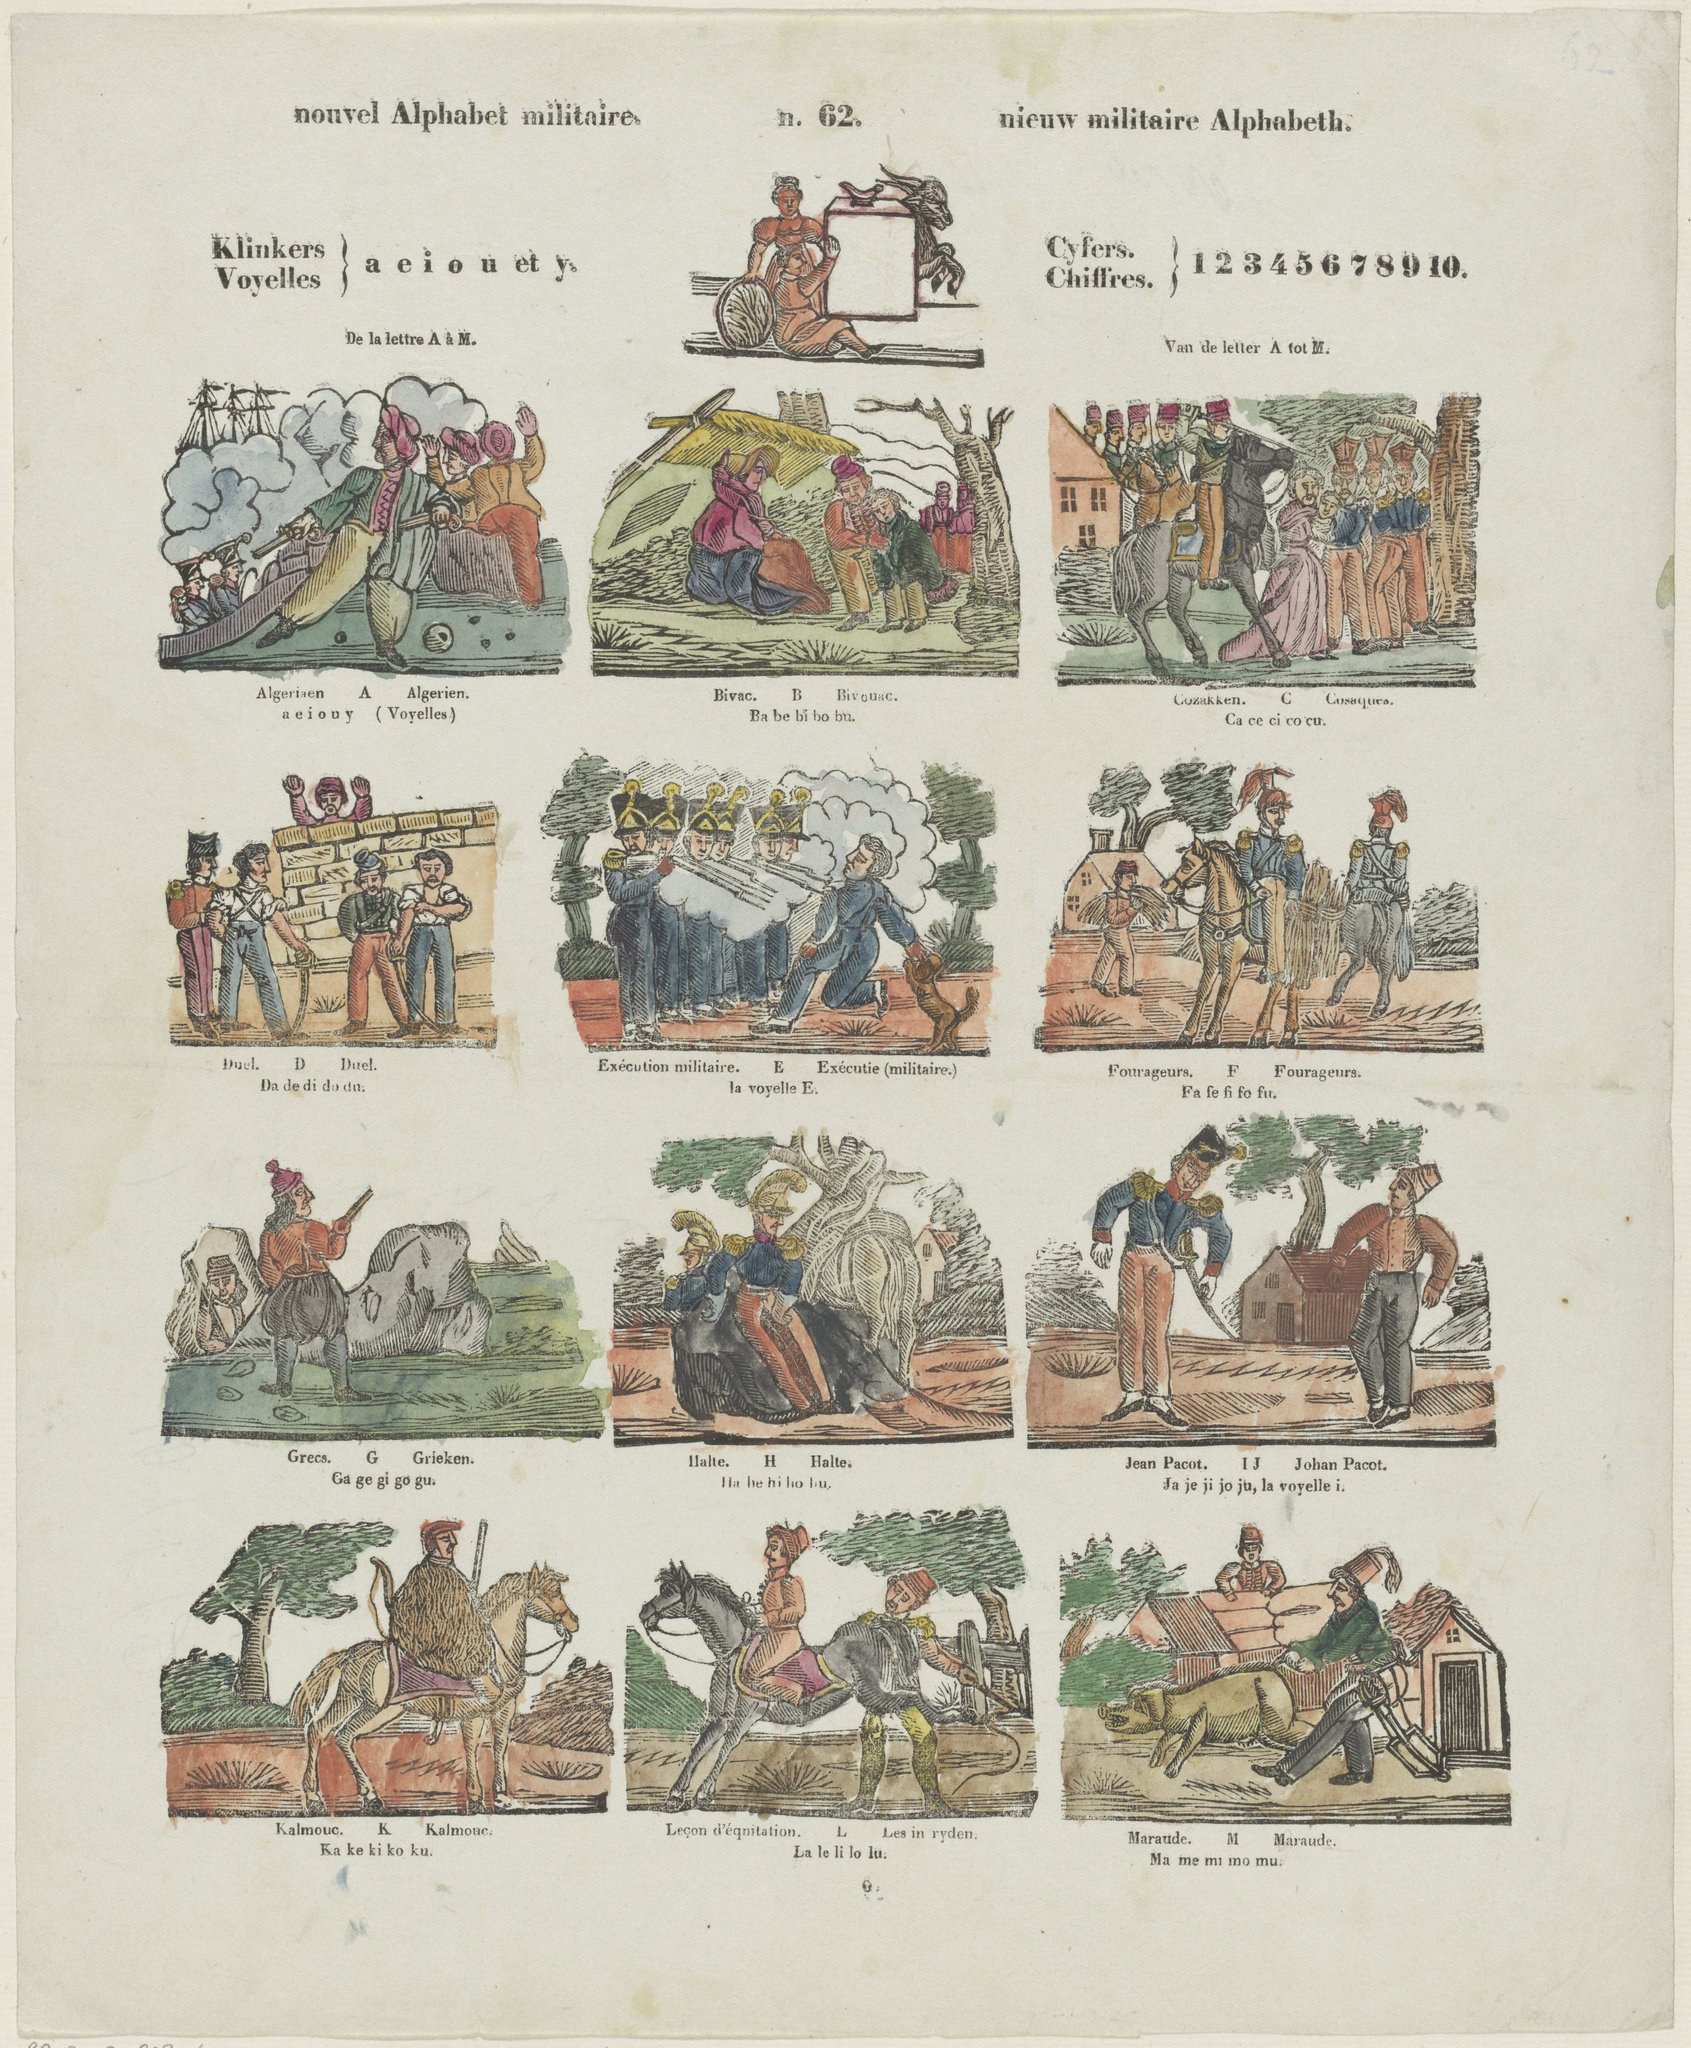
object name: print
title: Nouvel alphabet militaire / Nieuw militaire alphabeth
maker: Anonymous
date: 1833-1856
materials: paper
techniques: colour, letterpress printing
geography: turnhout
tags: letters, alphabet, script, the soldier; the soldier's life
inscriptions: collector's mark: Lugt 2760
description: Blad met 12 voorstellingen van de letters van het alfabet (A-M) geïllustreerd met militairen waarvan de woorden met de betreffende letter beginnen. Onder elke afbeelding een onderschrift in het Nederlands en in het Frans. Genummerd midden boven: n. 62.